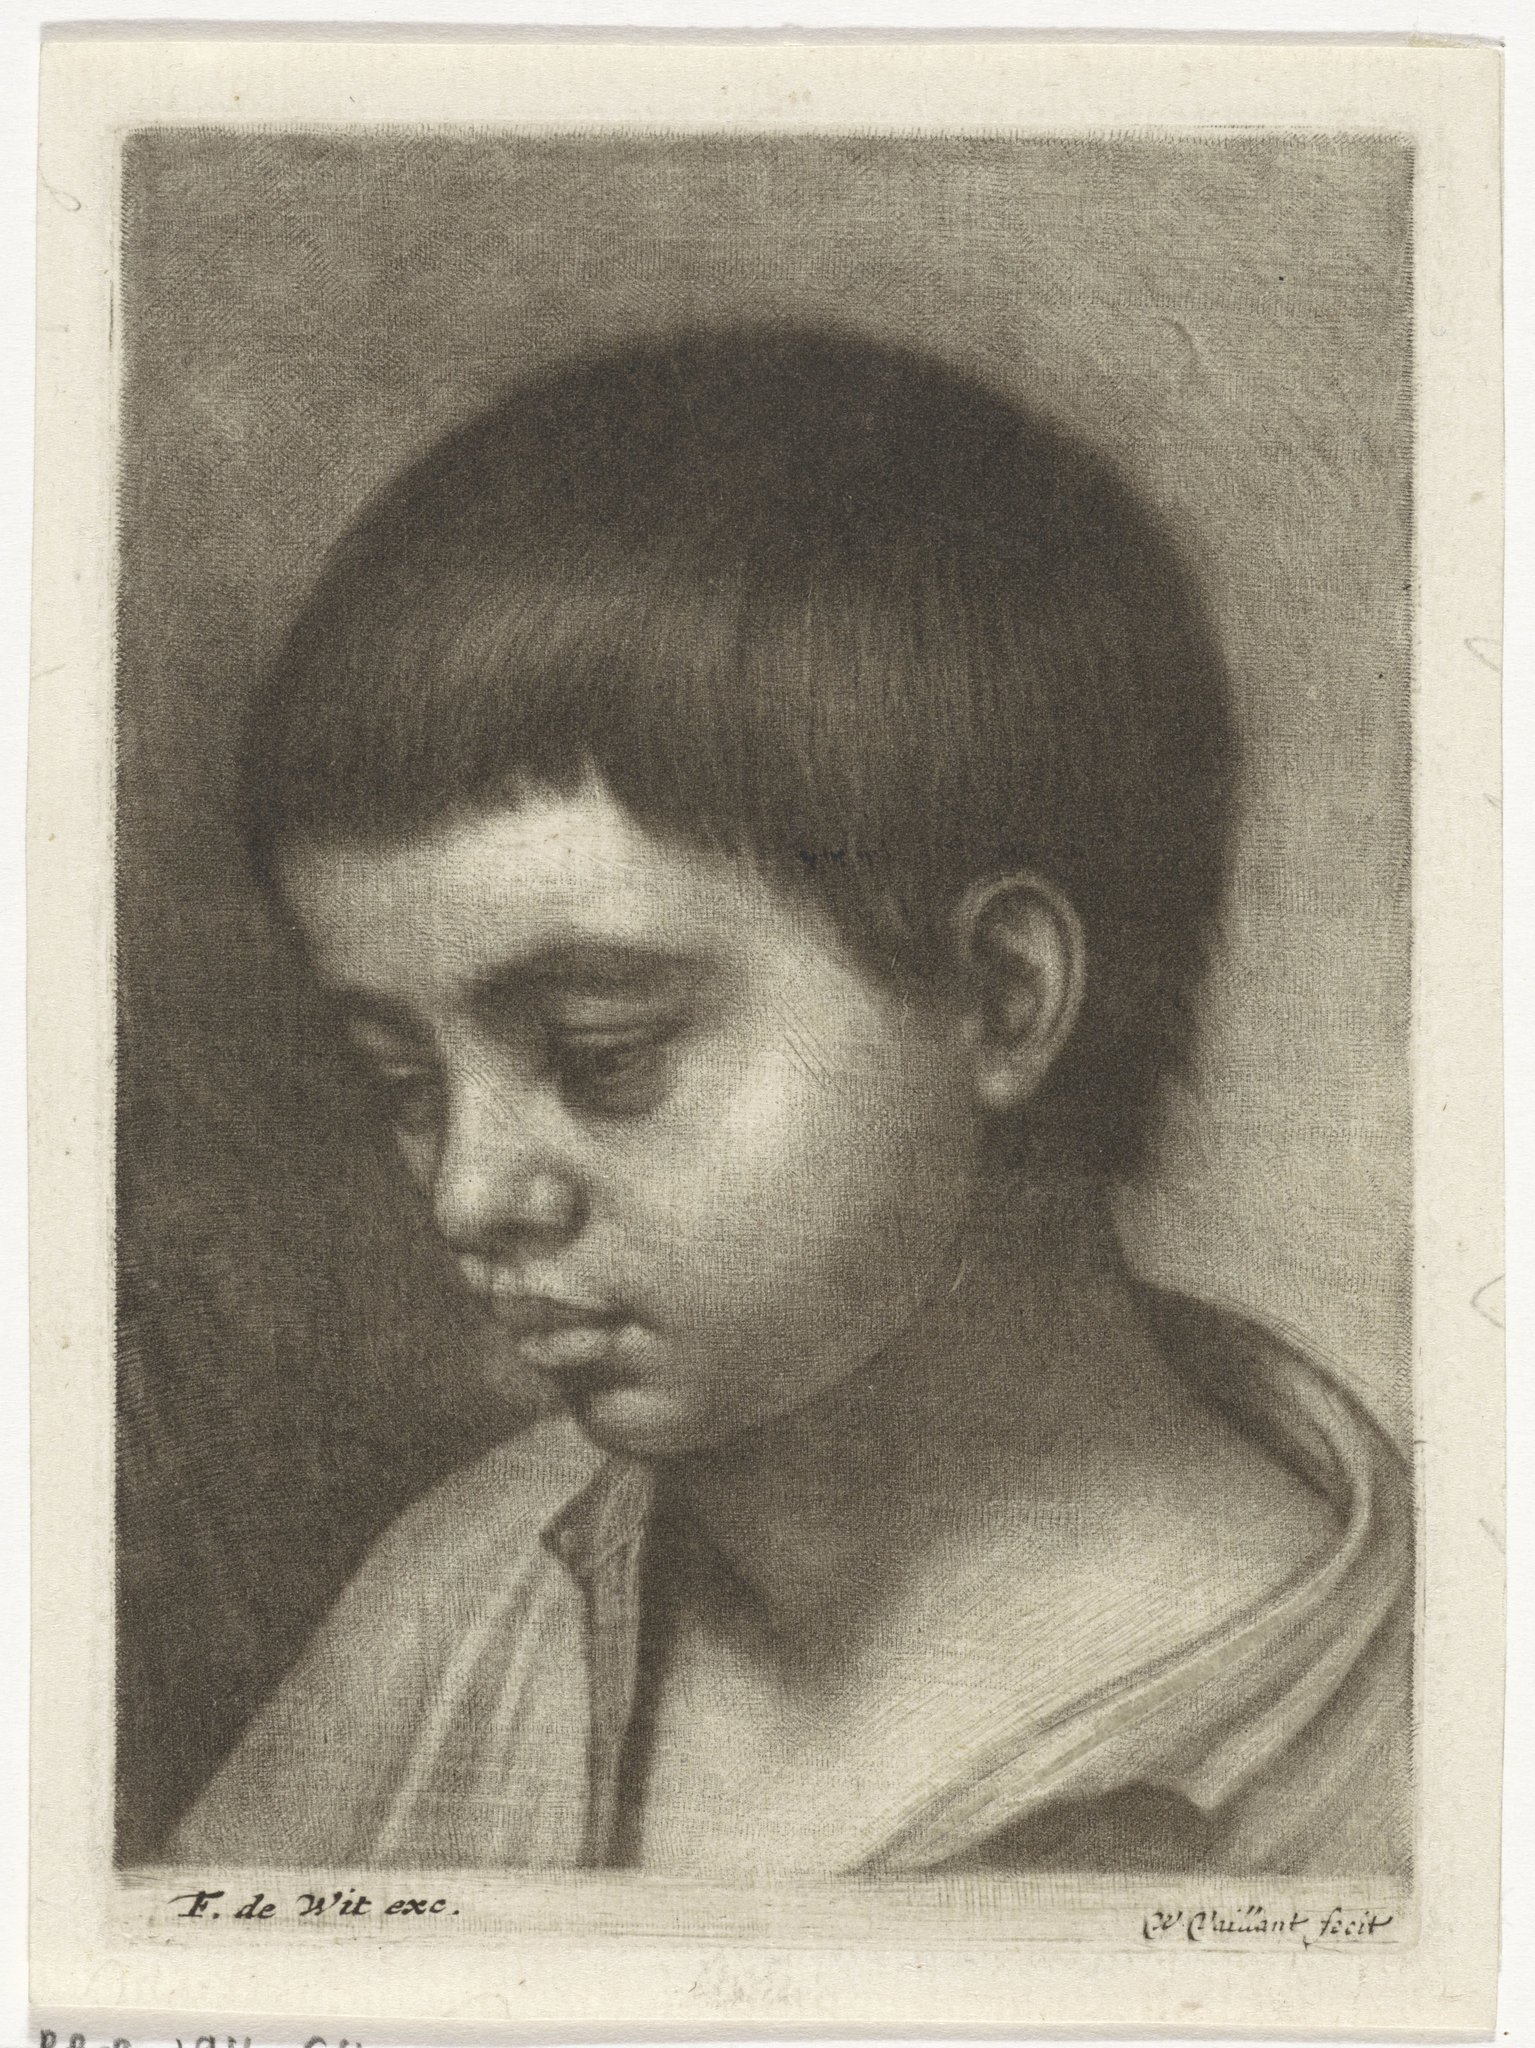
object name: print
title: Hoofd van een jongen, naar links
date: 1658-1677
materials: paper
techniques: mezzotint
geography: amsterdam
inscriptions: collector's mark: Lugt 2228